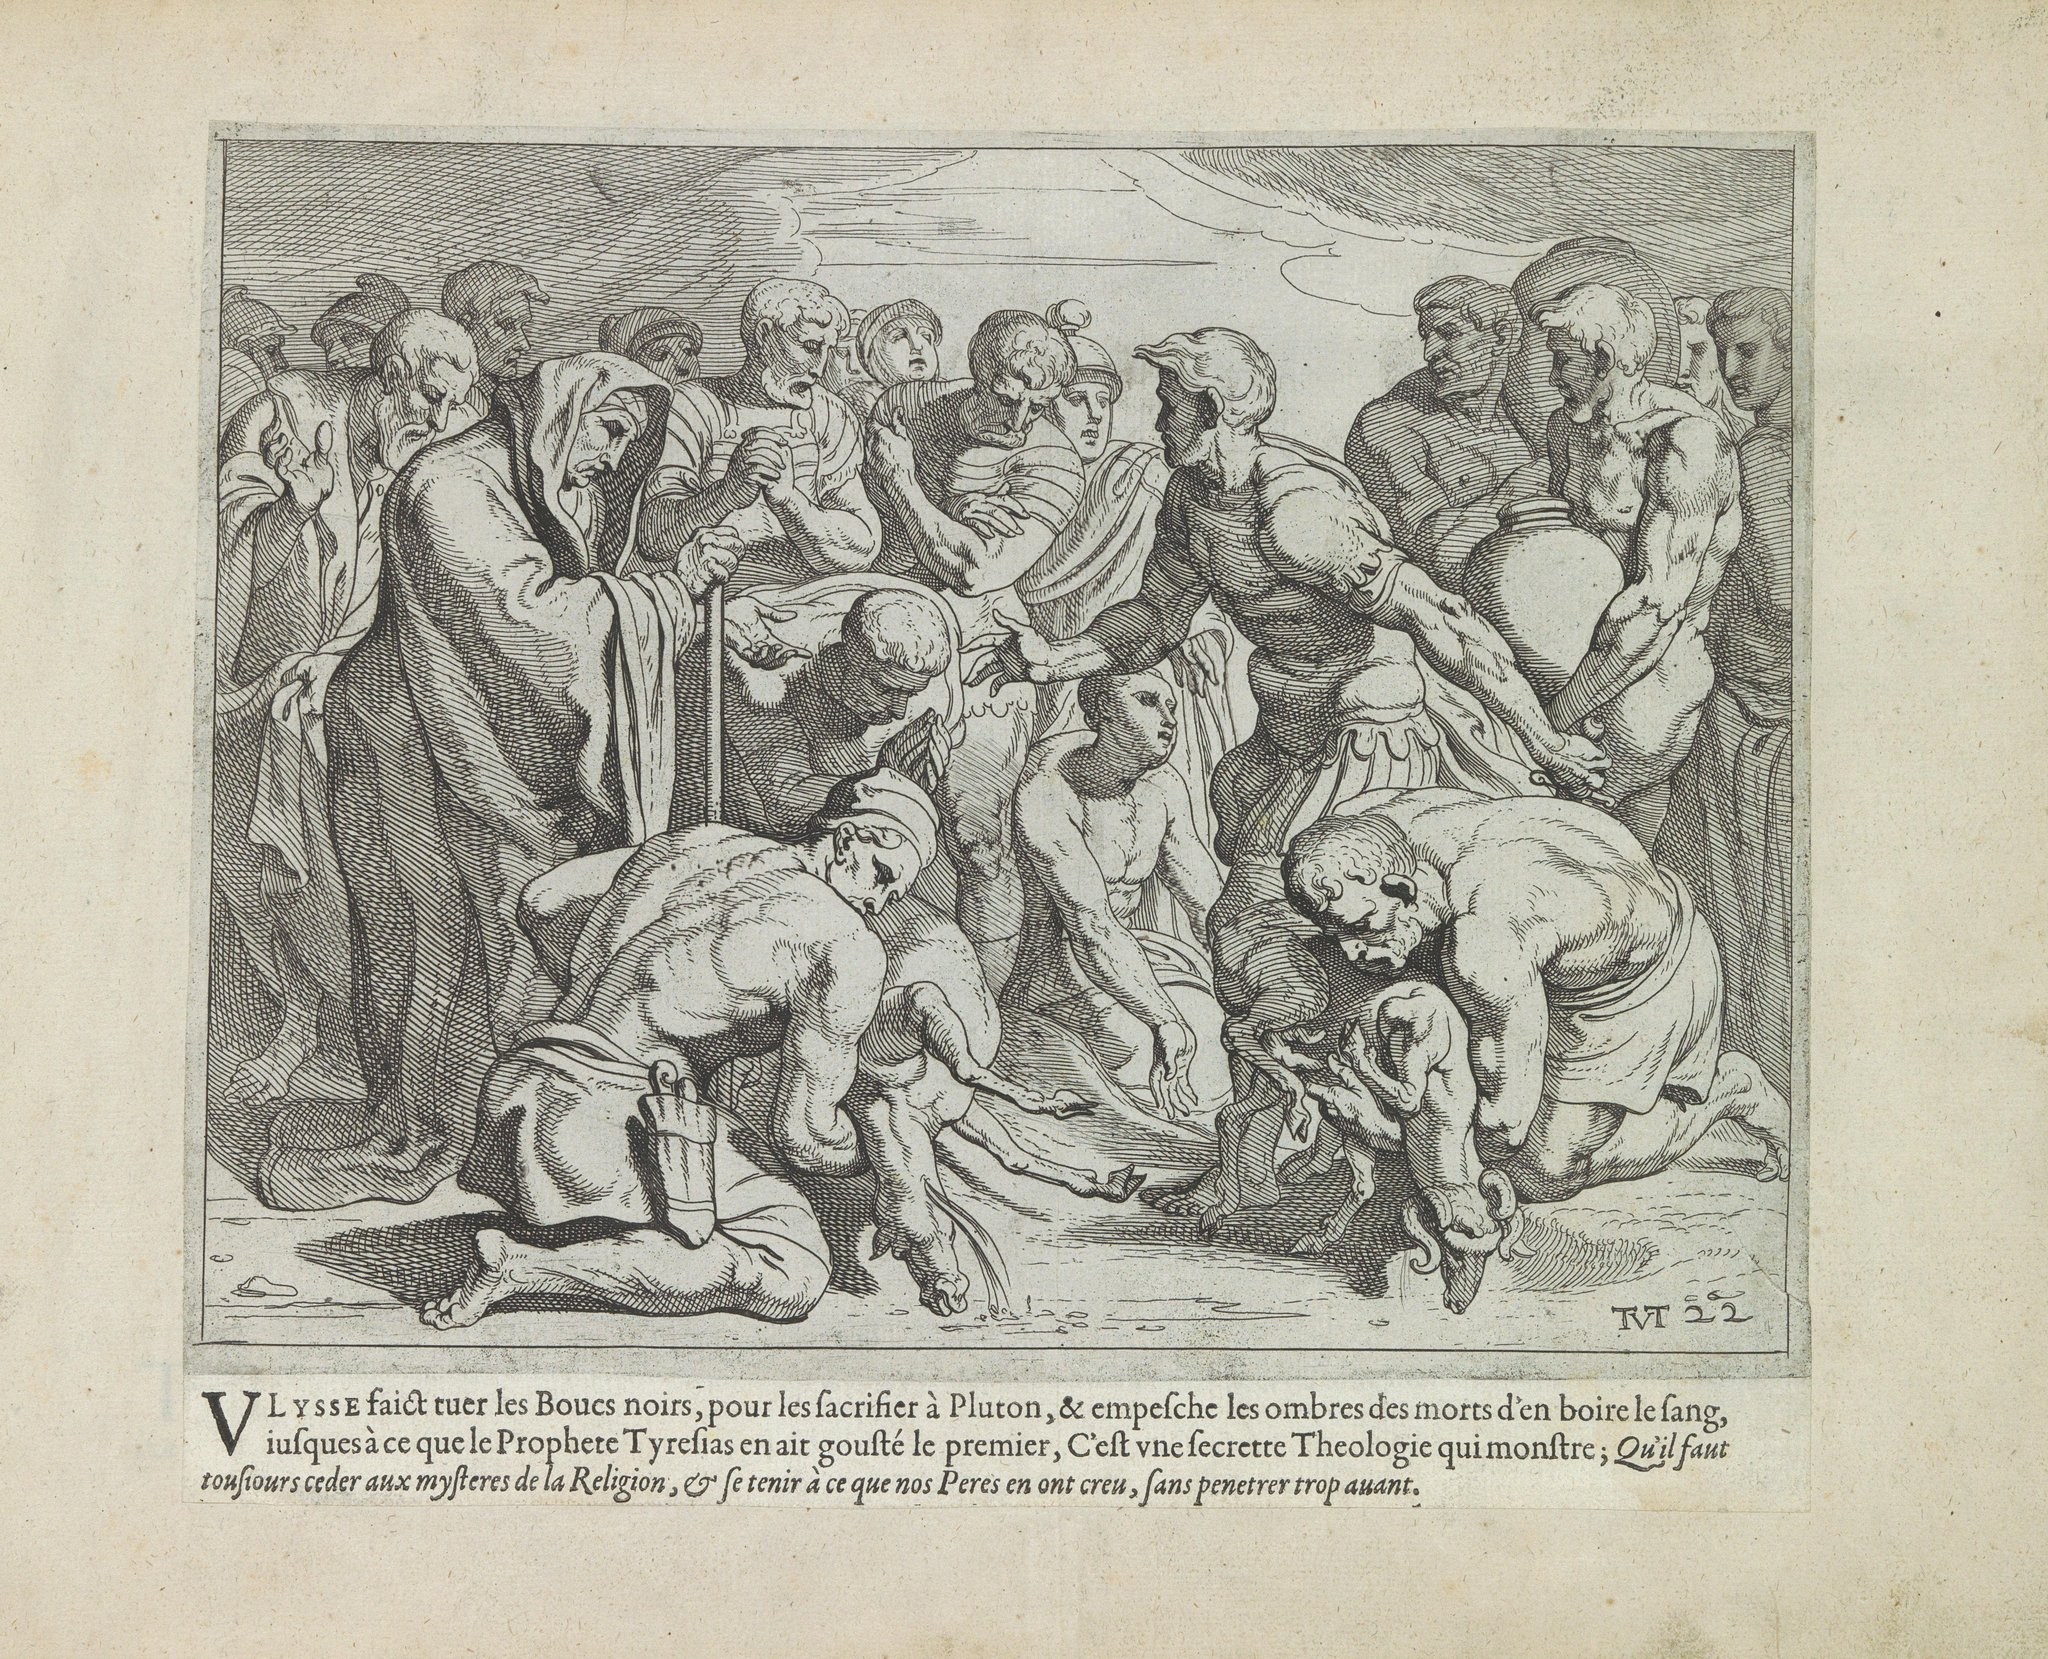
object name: album leaf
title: De werken van Odysseus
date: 1633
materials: paper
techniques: engraving, etching, letterpress printing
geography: paris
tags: ulysses in the underworld (homer, odyssey xi)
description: Odysseus offert in de onderwereld een zwarte ram en een zwart schaap. Op het bloed komen schimmen af, maar alleen Tiresias mag als eerste van het bloed drinken. De prent maakt deel uit van een album.